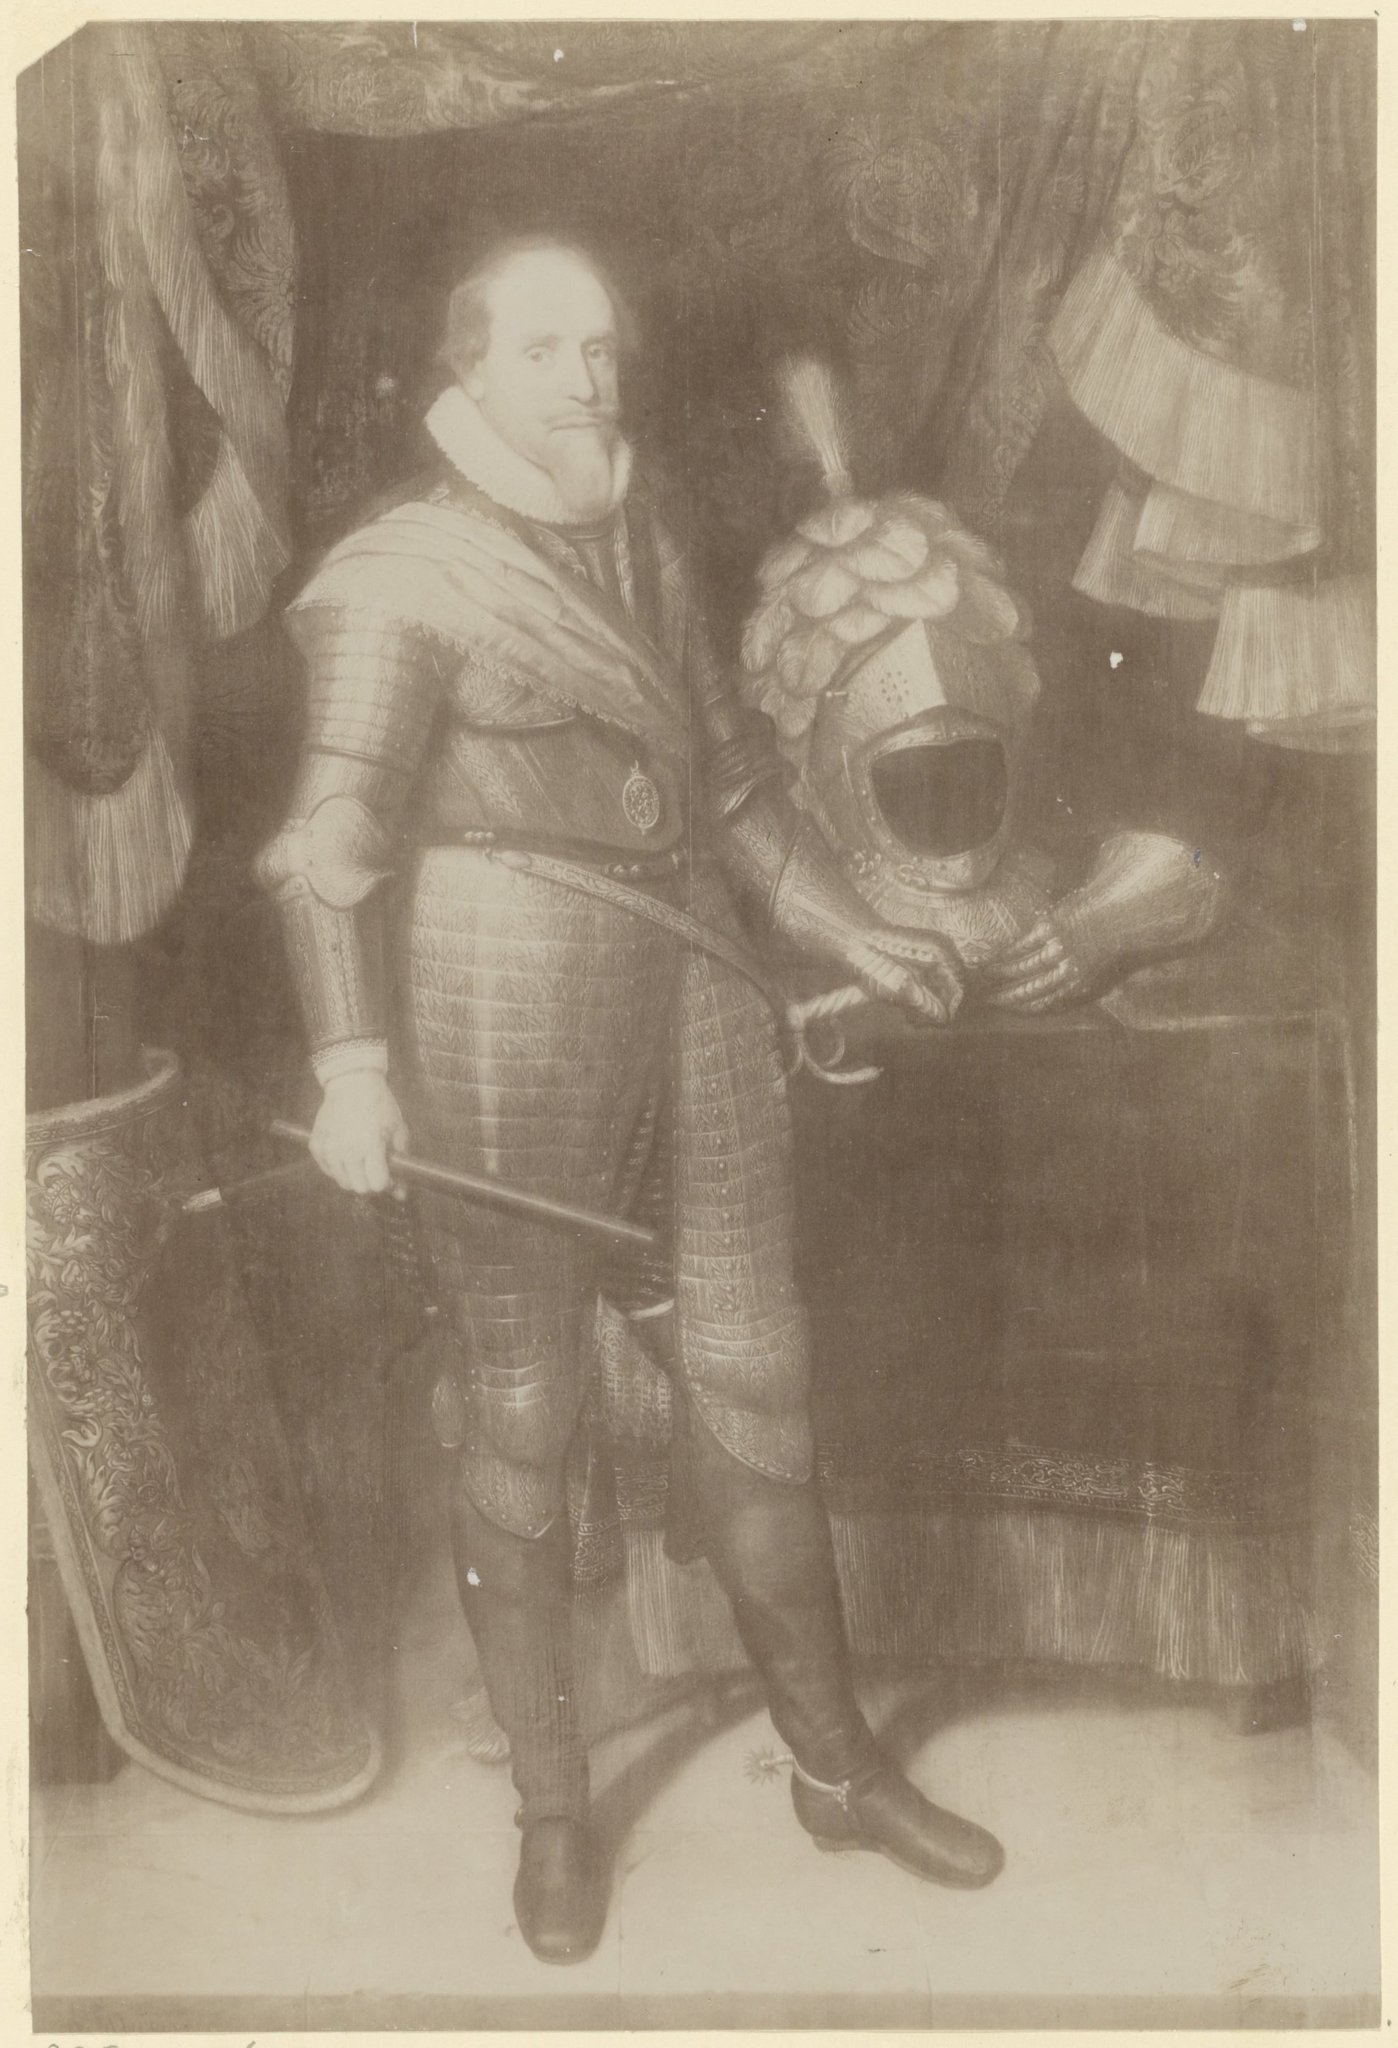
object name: photograph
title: Portret van Maurits, prins van Oranje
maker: Anonymous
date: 1850-1930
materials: photographic support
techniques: photography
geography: netherlands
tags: maurice (prince of orange)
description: De hier vermelde titel verwijst naar de hoogst verkregen titel van de geportretteerde, niet per se naar de titel die de geportretteerde op deze voorstelling draagt.